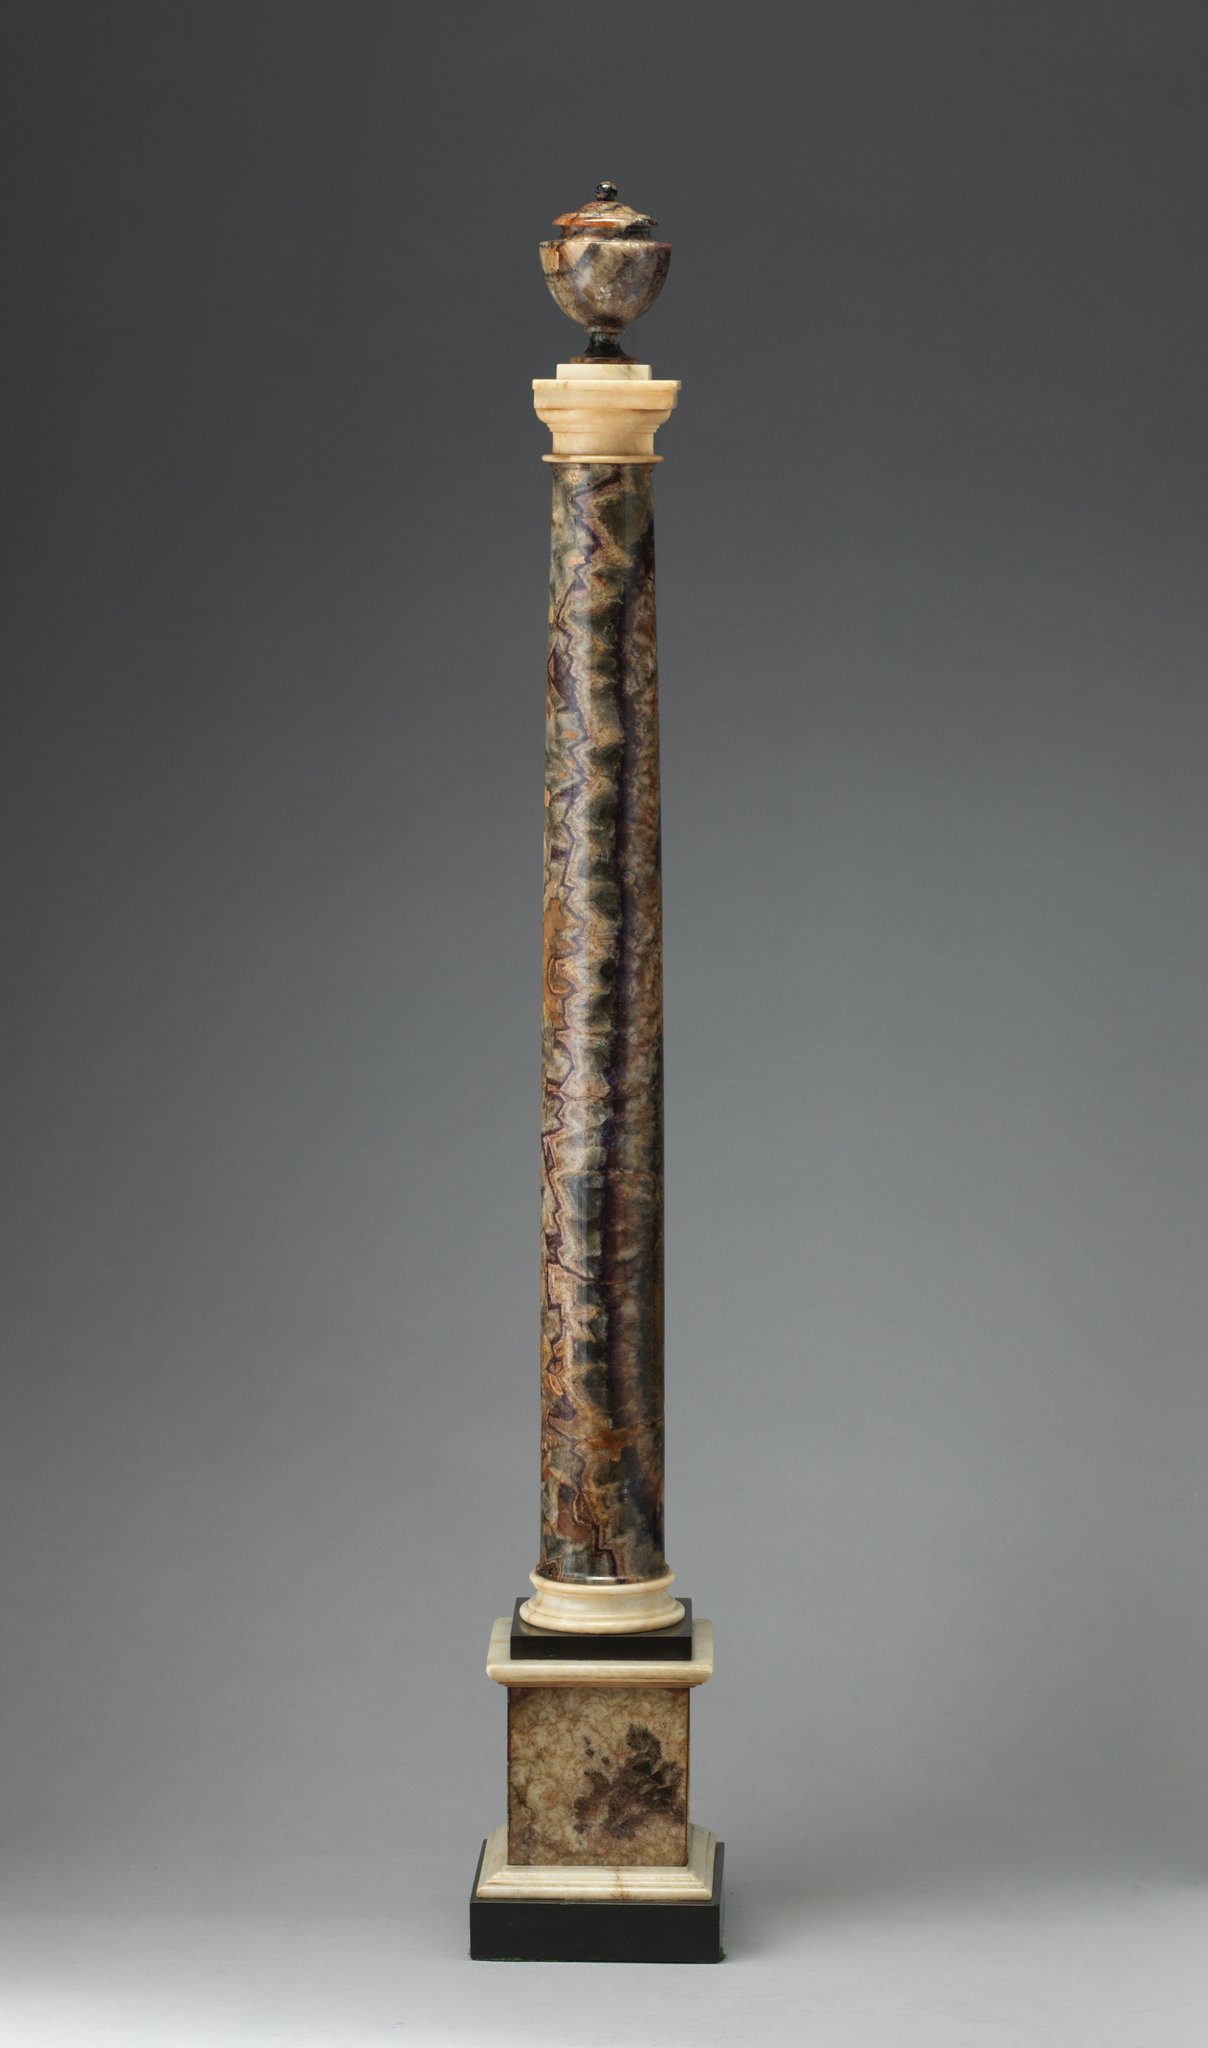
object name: column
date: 1701-1800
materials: marble